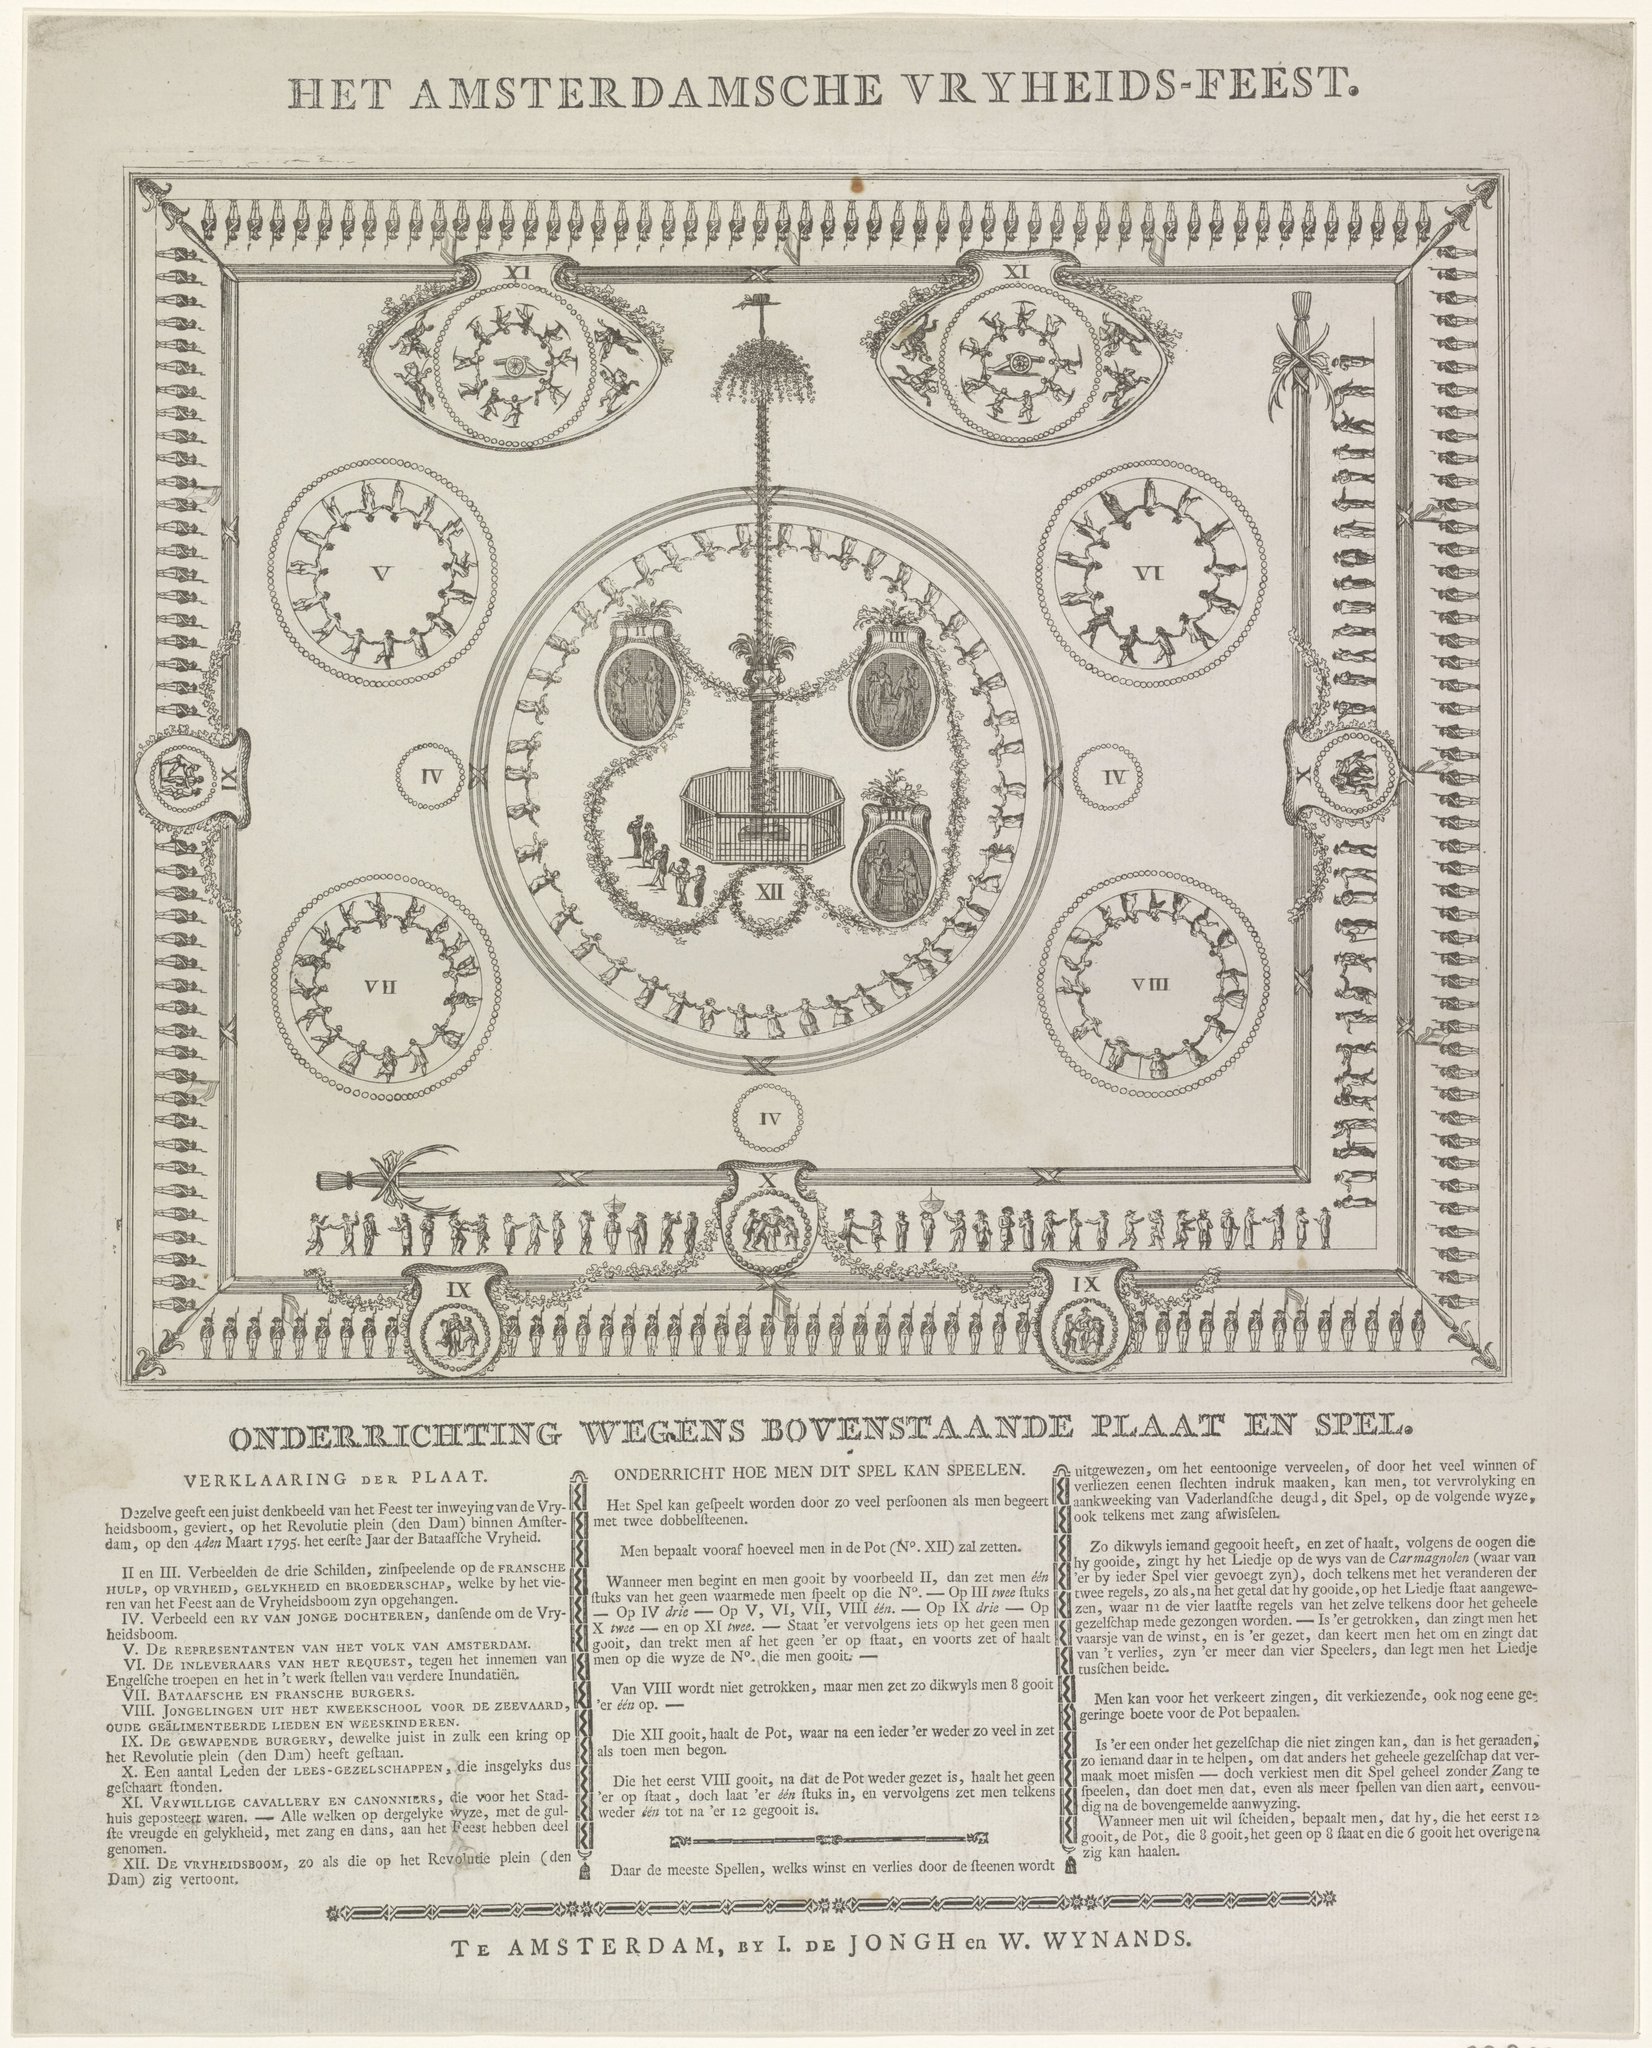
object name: print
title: Het Amsterdamsche Vryheids-feest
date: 1795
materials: paper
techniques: engraving, letterpress printing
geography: amsterdam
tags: board-games of chance, the soldier; the soldier's life, board-games, amsterdam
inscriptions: collector's mark: Lugt 2760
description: Bordspel met als thema de inwijding van de vrijheidsboom op het Revolutieplein (de Dam) te Amsterdam op 4 maart 1795. Verschillende vakken met Romeinse cijfers van I tot en met XII. Een omlijsting met vrijcorpisten. Onder het spel de spelregels in drie kolommen. Boven het spel de titel.